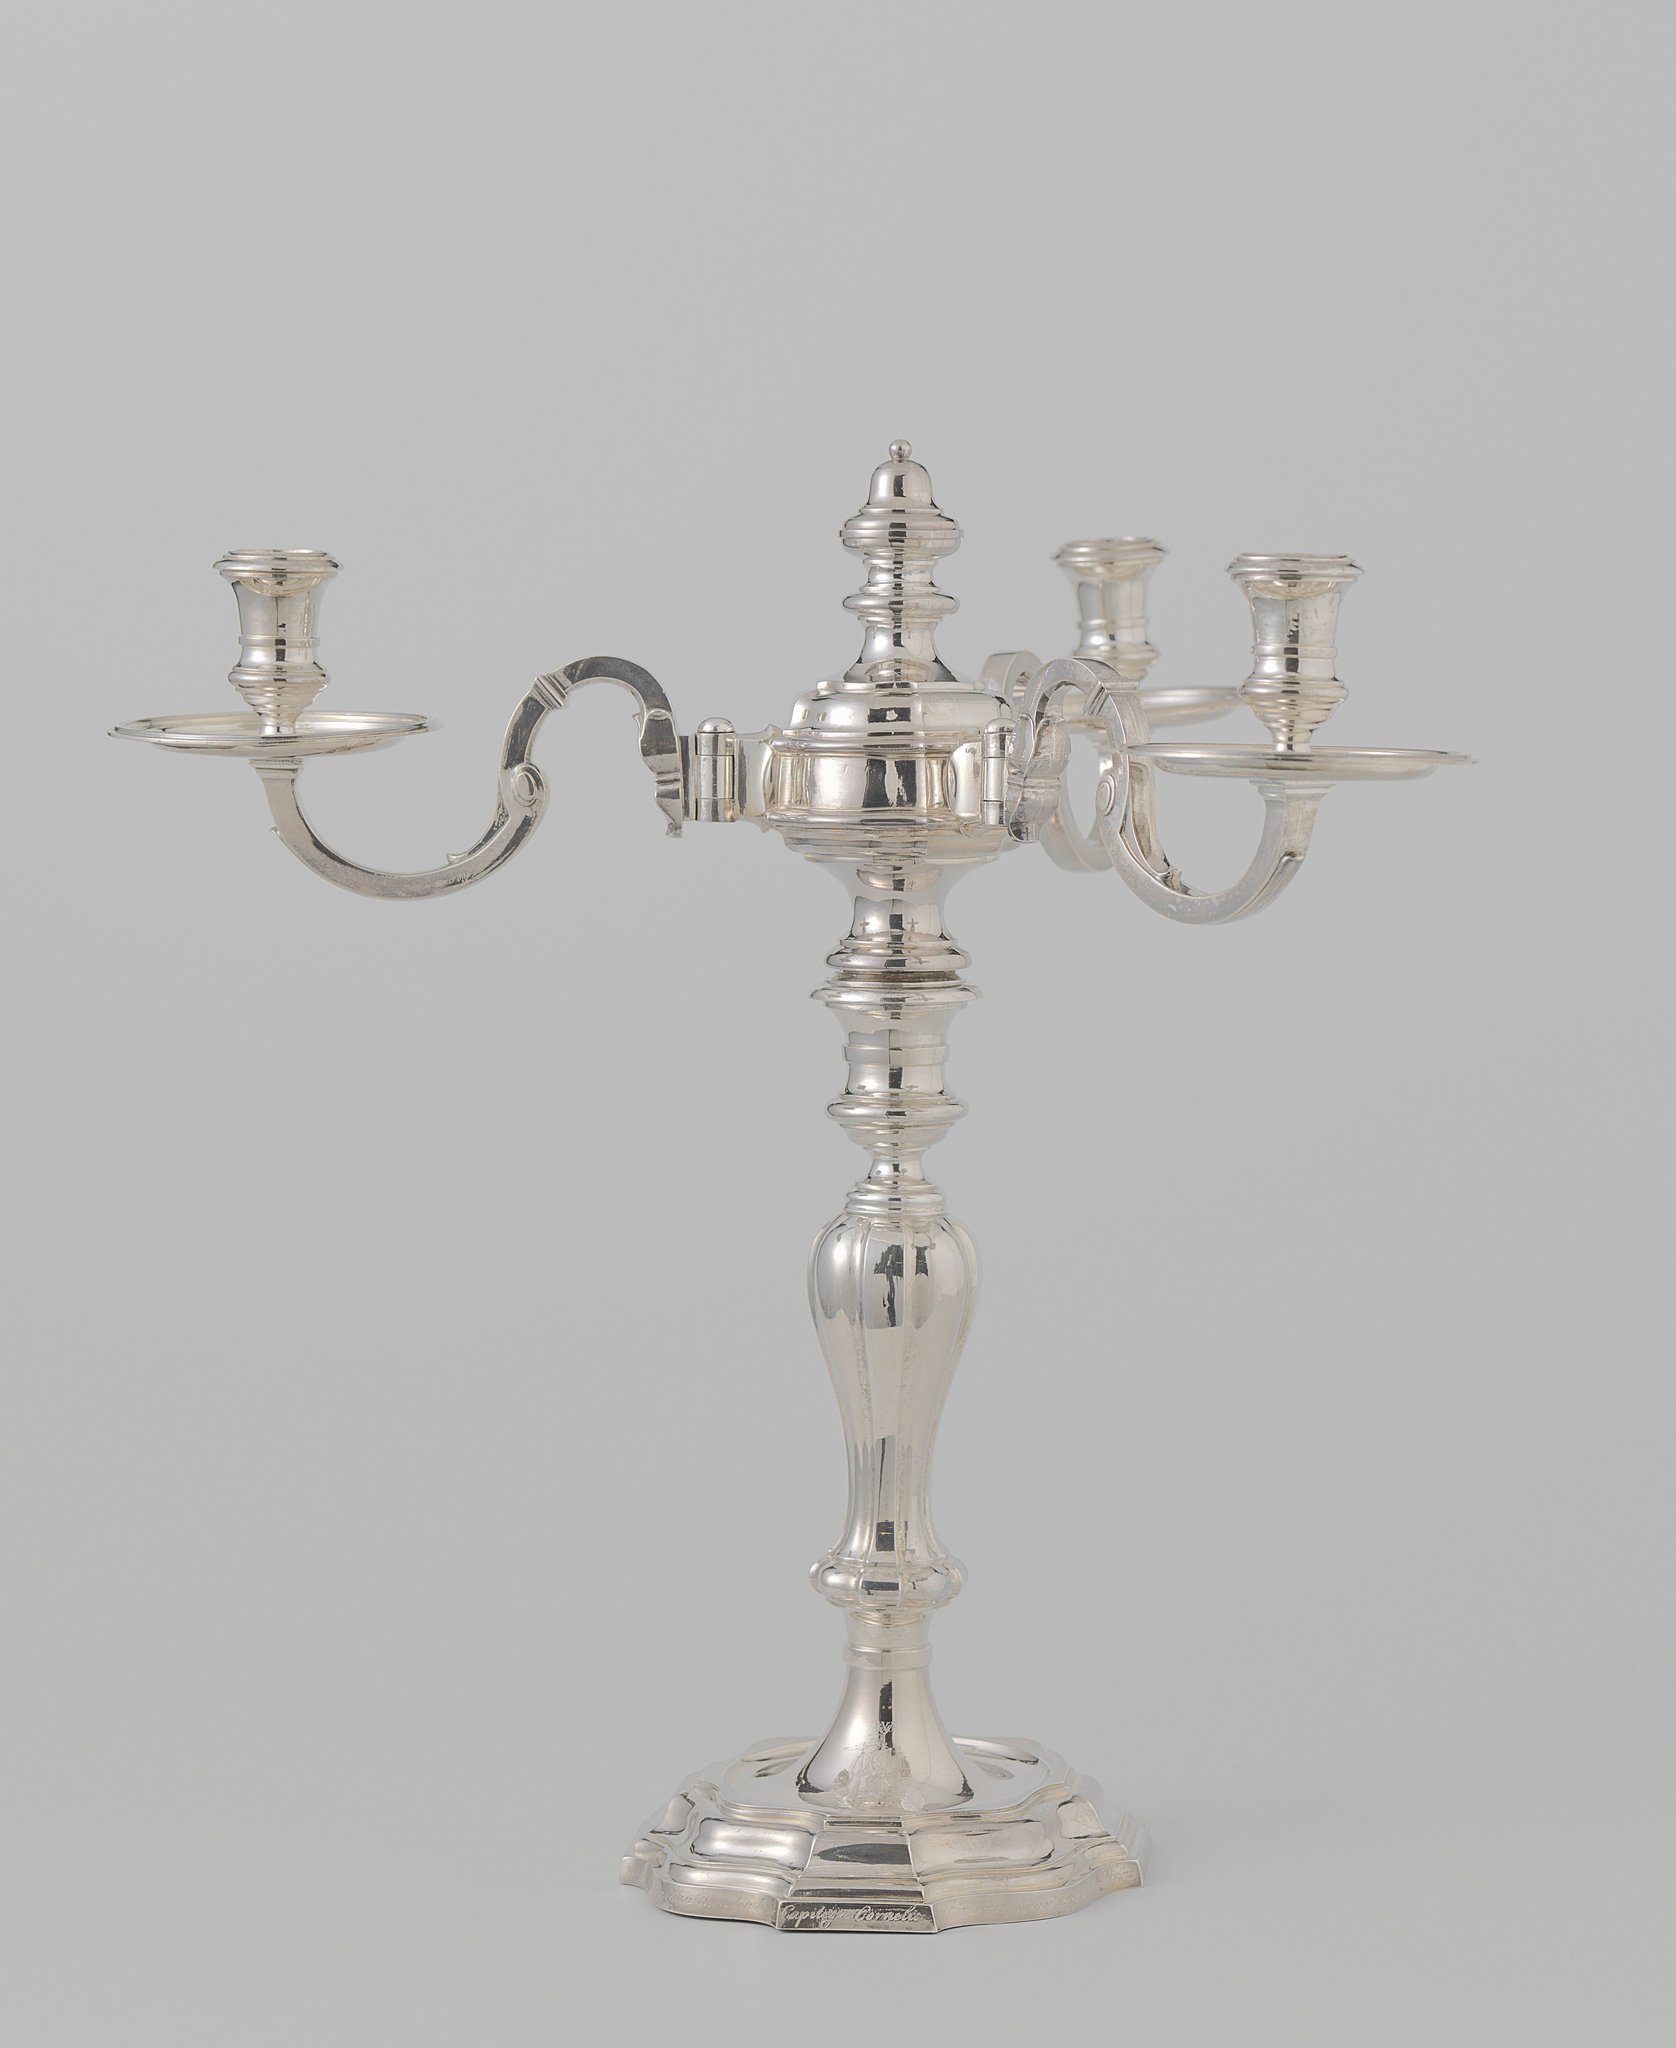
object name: candelabrum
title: Kandelaber, geschonken aan kapitein Cornelis Schrijver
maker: pieter mouritz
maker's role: silversmith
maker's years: 1706-1789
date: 1738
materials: silver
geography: amsterdam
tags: schrijver, cornelis schrijver, west-indische compagnie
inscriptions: inscription: ‘De Generale geoctroijeerde West indische Compagnie heeft dit Present gedaan aan de heer Capiteyn Cornelis Schrijver, voor zijne Veelvuldige Occupasien en gedane diensten aan deselve in den Jare 1737 beweese’, maker's mark: ‘PM ter weerszijden van een bloem in ovaal’, alloy mark: ‘Hollandse leeuw’, date letter: ‘D’, town mark: ‘Amsterdam’, inscription: ‘GWC’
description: Pair of candelabra presented by the Dutch West India Company to Captain Cornelis Schrijver. Silver. Amsterdam, 1738, attributed to Pieter Mourits. Mrs E.J.C. VerLoren van Themaat-de Pesters bequest, 1919.